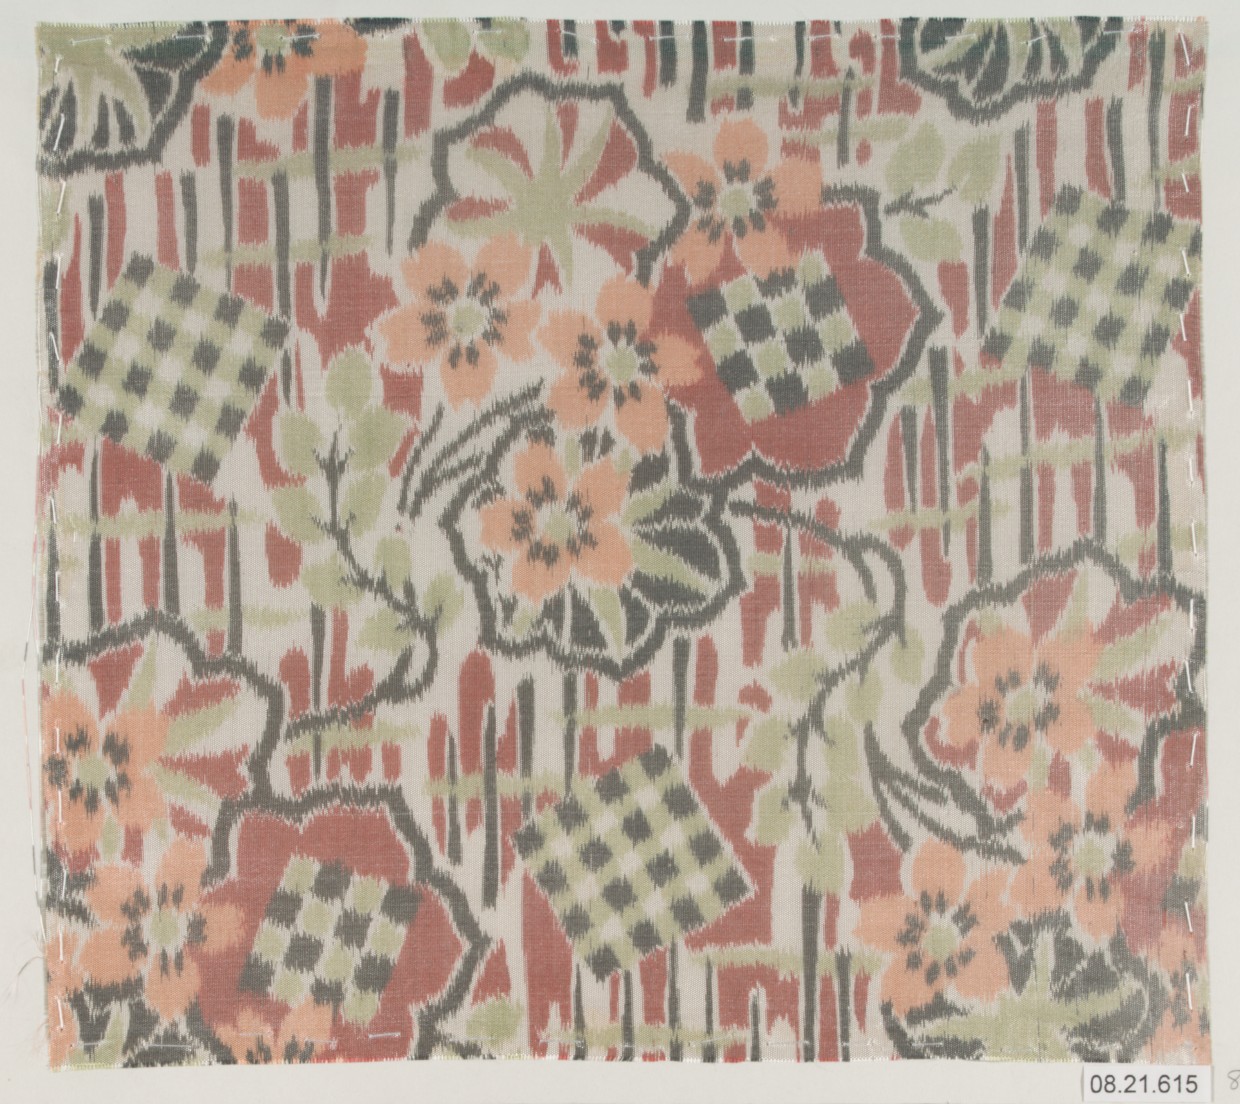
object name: textile sample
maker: Anonymous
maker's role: designer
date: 1900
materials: silk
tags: flowers